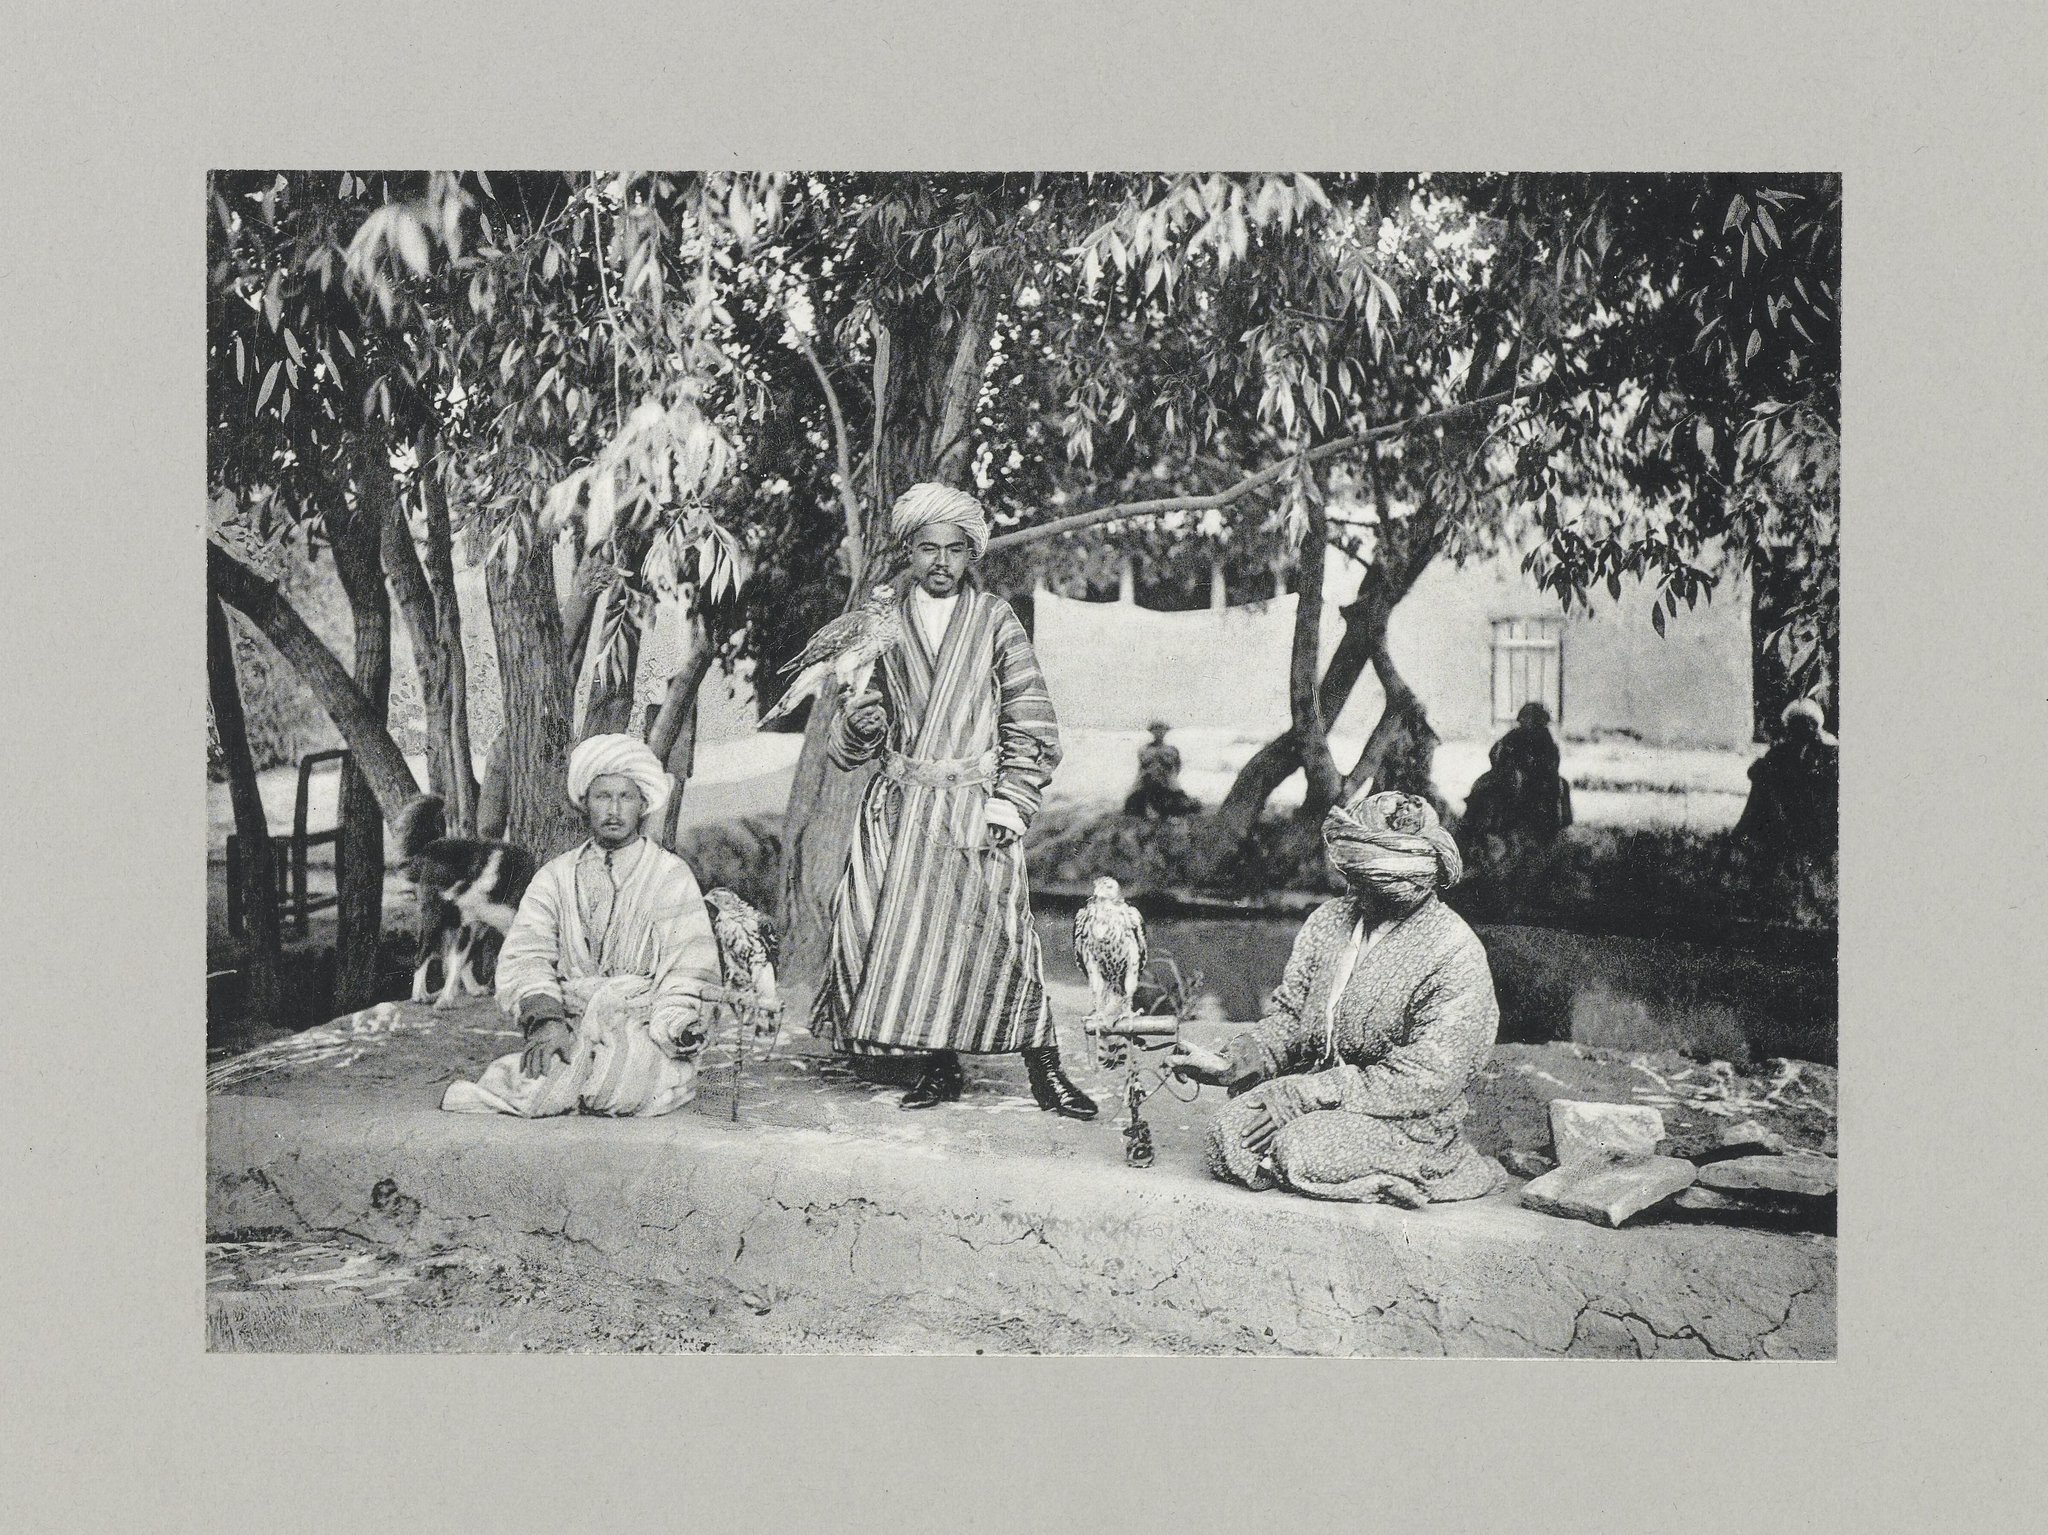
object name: photomechanical print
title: Drie Turkestaanse mannen met valken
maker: Anonymous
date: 1895-1915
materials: cardboard, paper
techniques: photograph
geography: turkestan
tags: turkestan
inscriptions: annotation: ‘25. Valken.’